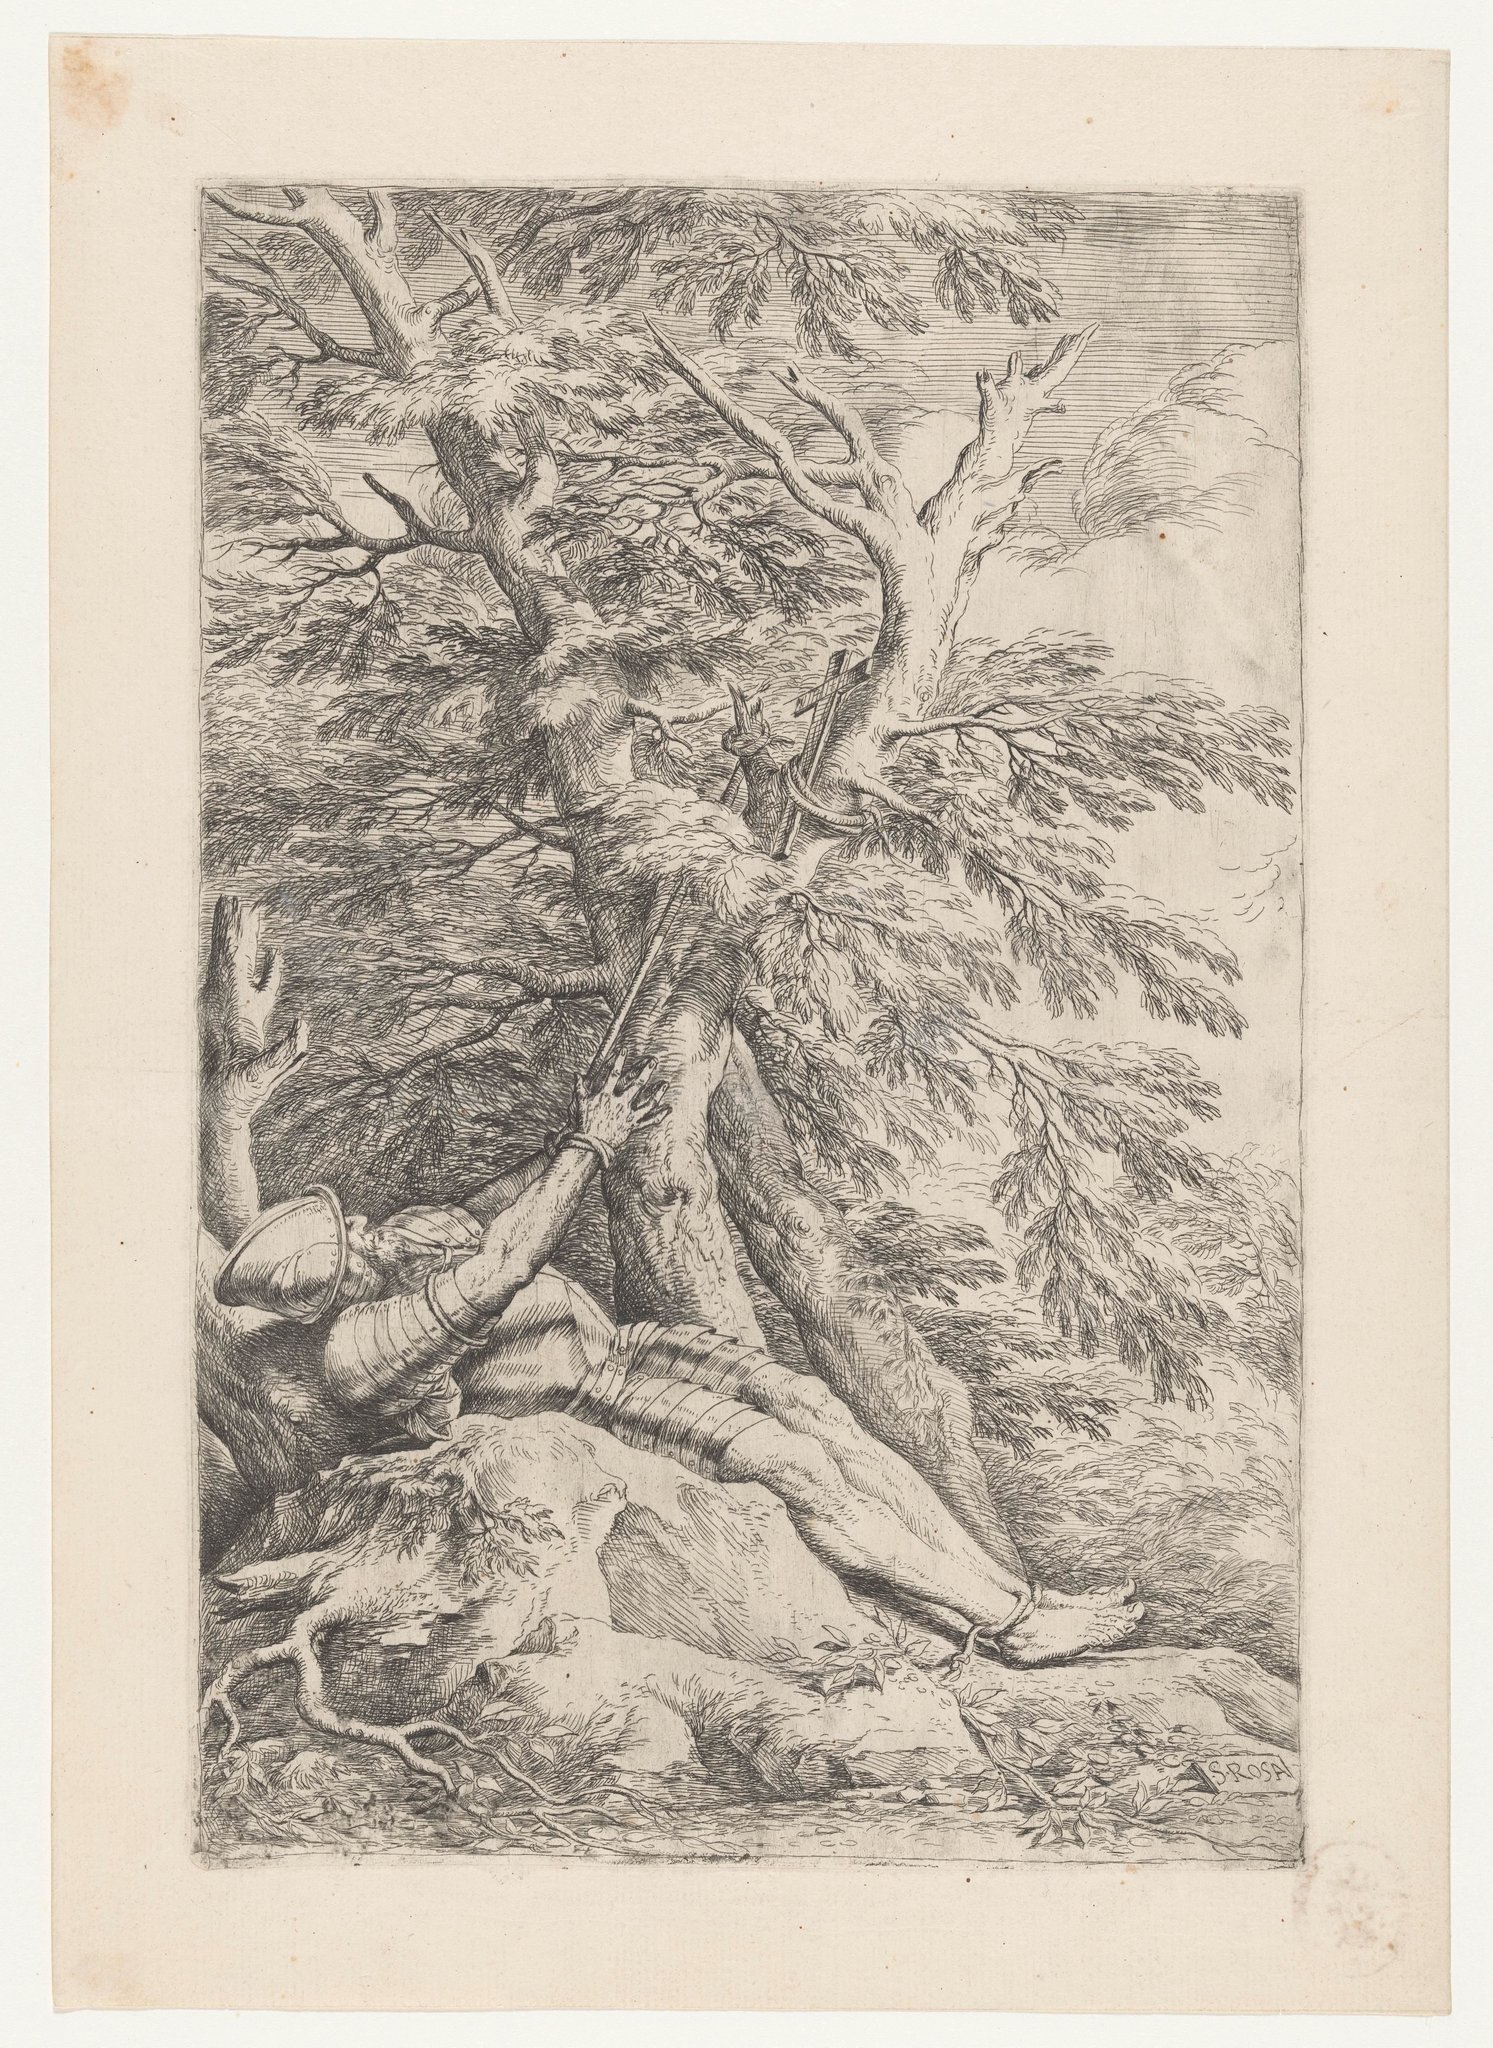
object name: print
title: Heilige Willem van Maleval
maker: salvator rosa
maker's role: draughtsman, painter, print maker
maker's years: 1615-1673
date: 1661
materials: paper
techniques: drypoint, etching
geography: italy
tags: the hermit william of maleval (the great); possible attributes: book, coat of mail, dragon under feet, helmet, shield, rosary, t-shaped staff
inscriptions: collector's mark: Lugt 240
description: De heilige Willem van Maleval in harnas met helm, zijn handen vastgebonden aan de tak van een boom. Aan een andere tak van de boom is een kruis gebonden.